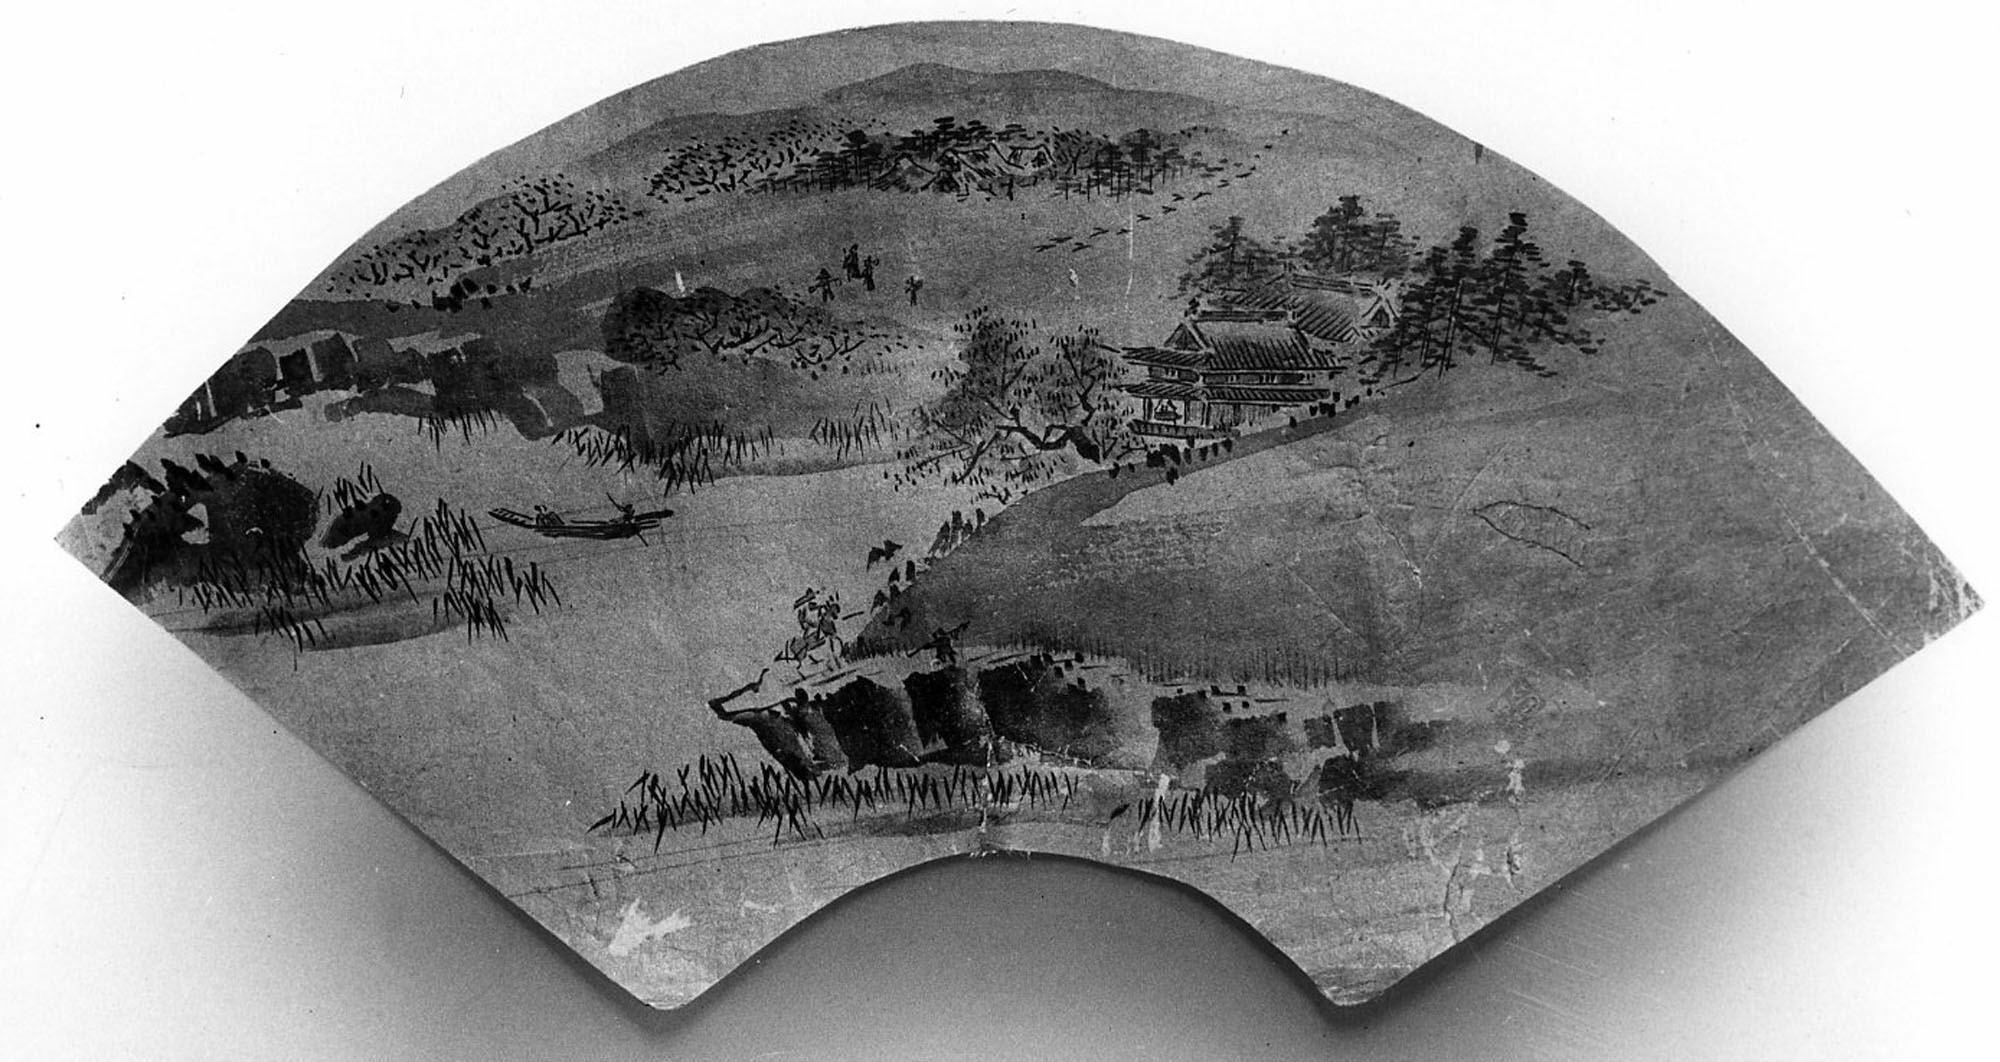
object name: fan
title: Landscape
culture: japanese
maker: kano motonobu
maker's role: artist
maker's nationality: japanese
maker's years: 1477-1559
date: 1601-1700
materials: paper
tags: landscapes,boats